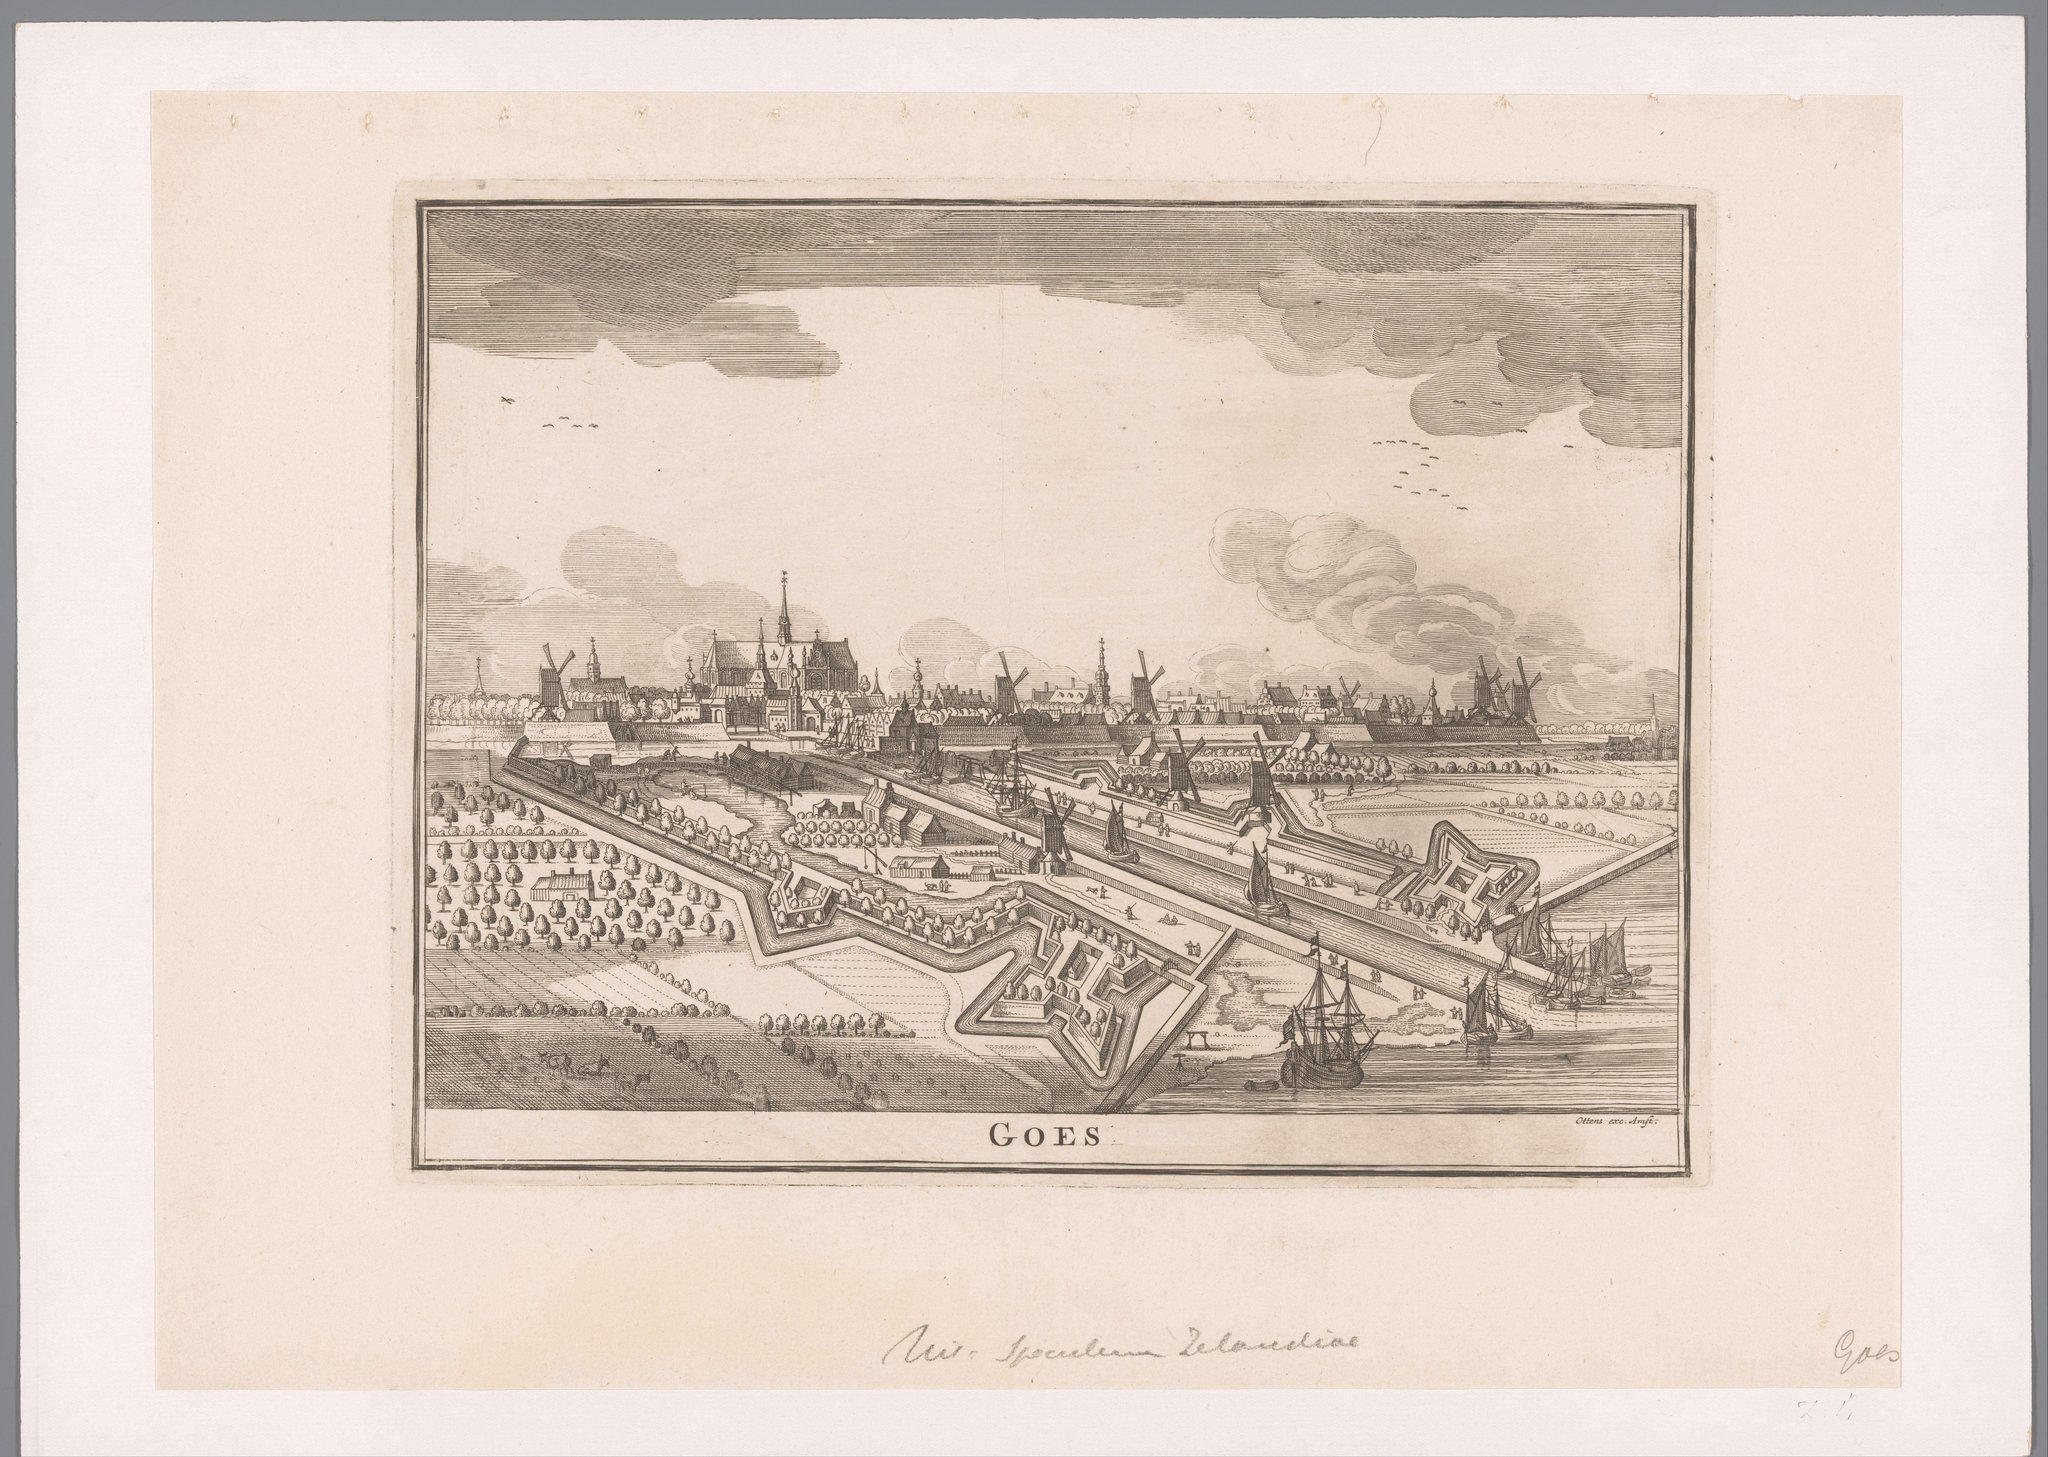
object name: print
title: Gezicht op Goes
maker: pieter hendricksz. schut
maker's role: print maker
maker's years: 1618-1660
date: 1719-1725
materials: paper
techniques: etching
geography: amsterdam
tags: prospect of village, silhouette of village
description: Prent uit: Speculum Zelandiae dat is een beschryvinge ofte afbeelding der steden, ambachts-heerlijckheden, dorpen castelen, ridderlijcke hofsteden, huysen en gebouwen gelegen inde eylanden en de graeflijckheyt van Zeelandt. Amsterdam: weduwe Ottens en Zoonen, [1719-1725]. Eerdere staat/staten van prenten is/zijn gebruikt in eerdere uitgaven van 'Speculum Zelandiae' en in andere publicaties uitgegeven door Zacharias Roman en Nicolaes Visscher (I). De eerste publicatie waarin de eerste staat van de prent rechtsonder voorkomt dateert uit 1656. De eerste publicatie waarin de eerste staat van de andere drie prenten voorkomt dateert uit 1657.